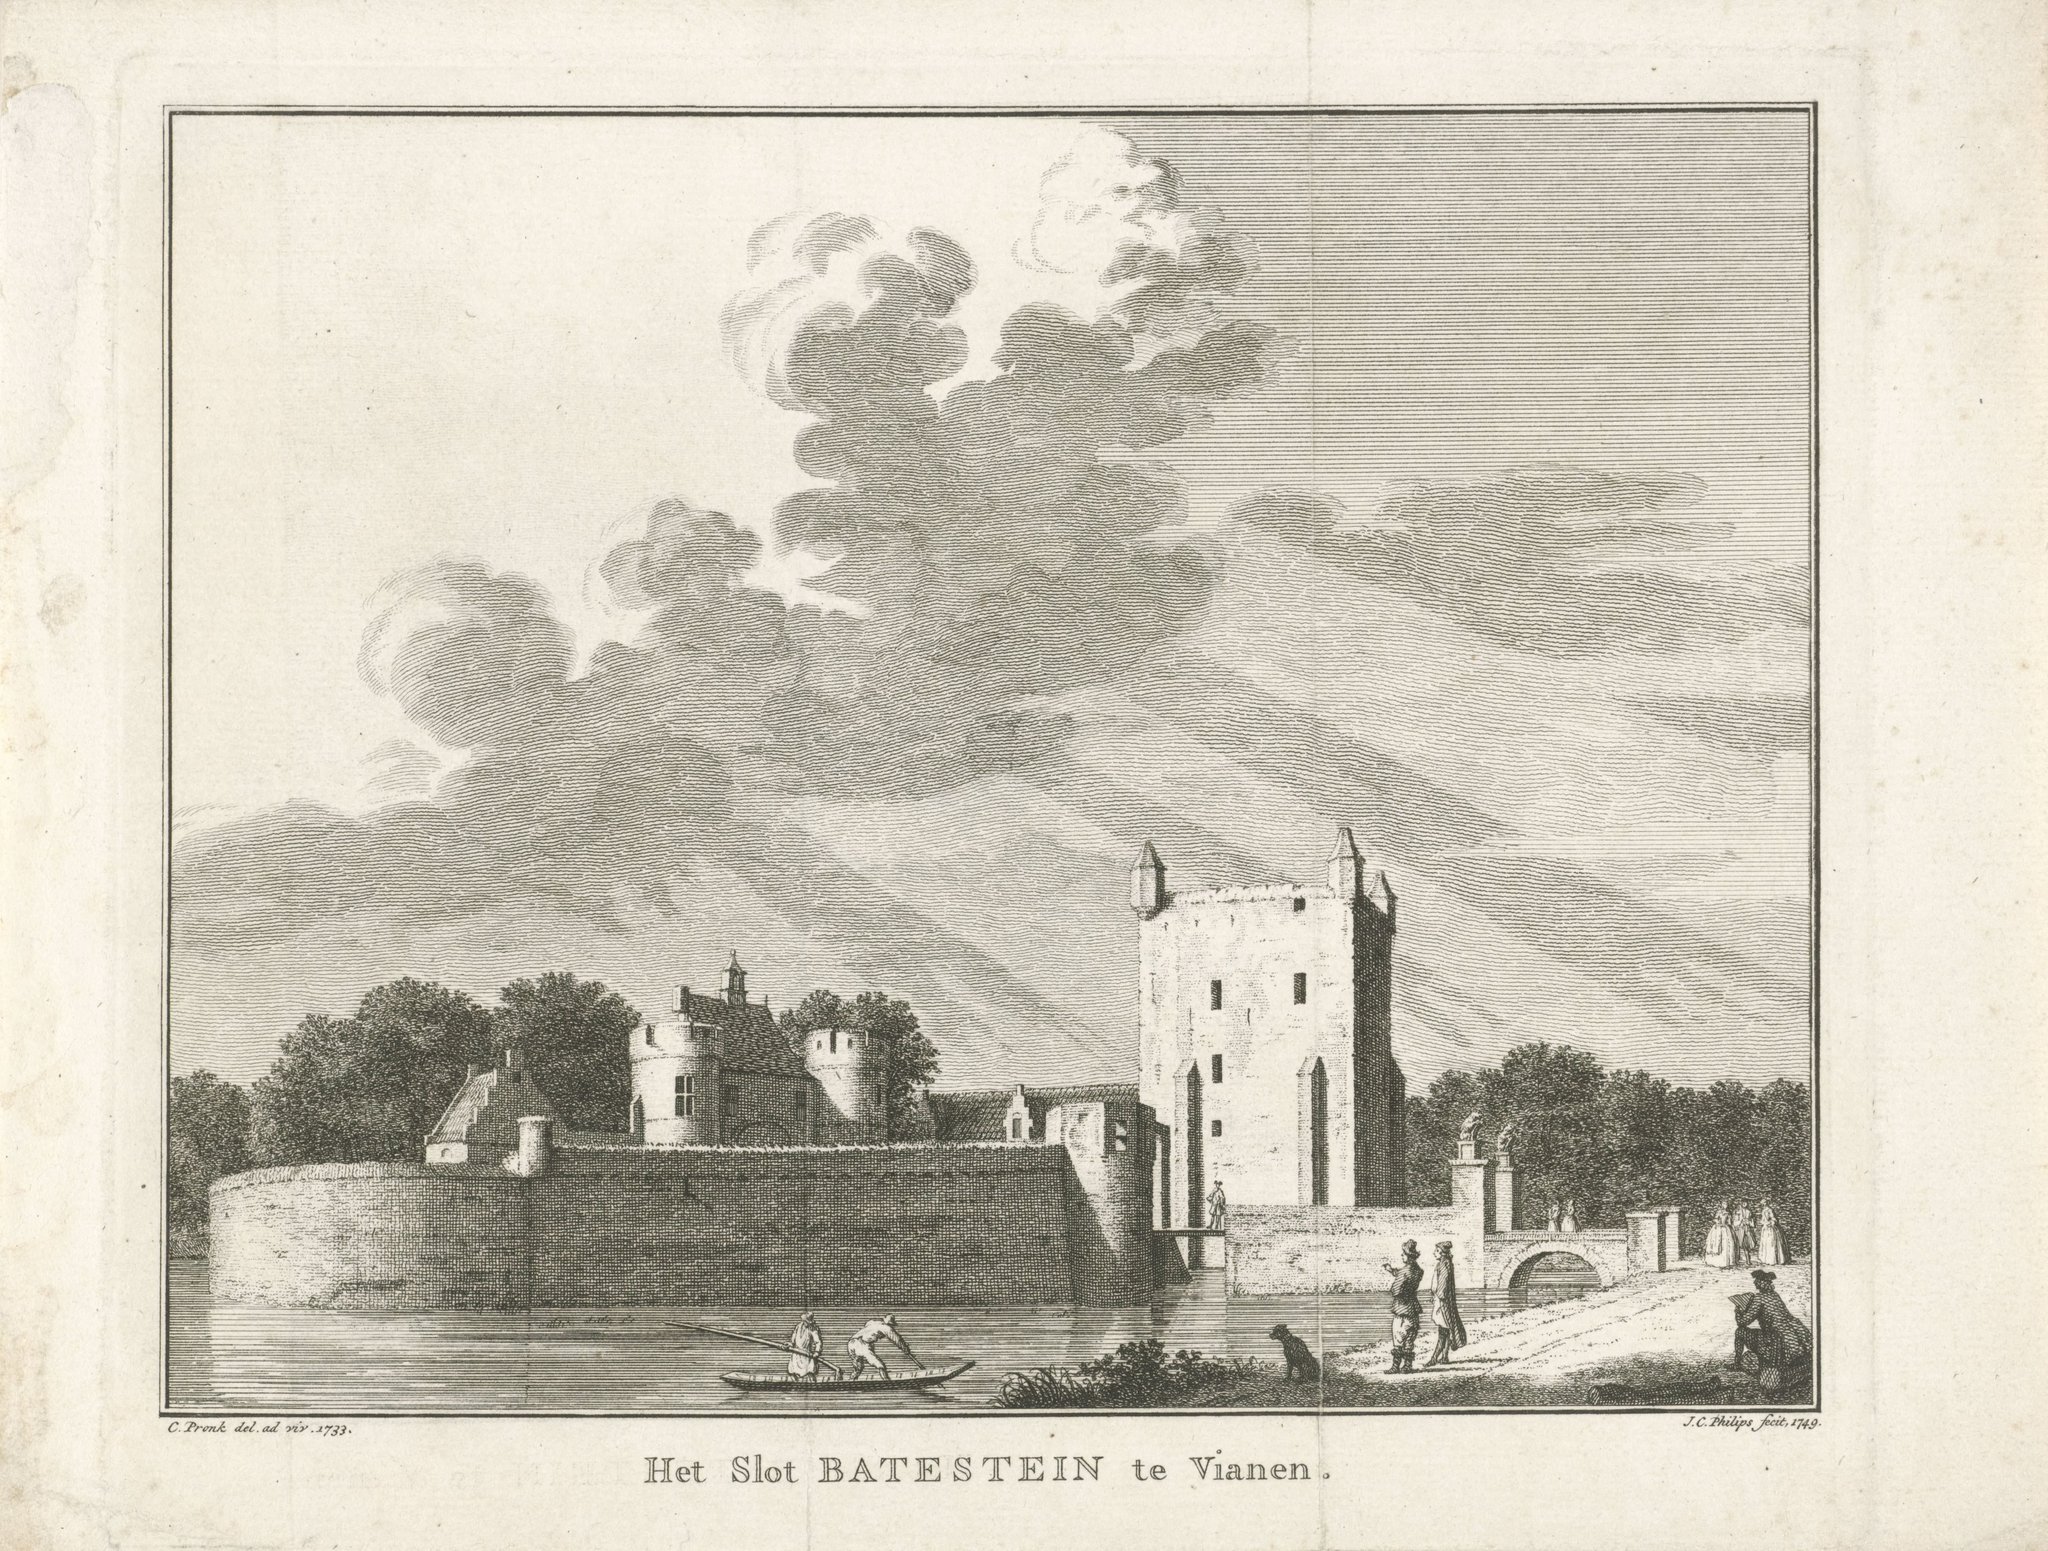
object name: book illustration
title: Gezicht op Kasteel Batestein, 1733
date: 1749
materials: paper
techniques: etching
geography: netherlands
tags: castle, rowing-boat, canoe, etc.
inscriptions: collector's mark: Lugt 2228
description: Gezicht op Kasteel Batestein te Vianen, in de situatie omstreeks 1733. Op de voorgrond twee mannen in een roeiboot op de slotgracht.